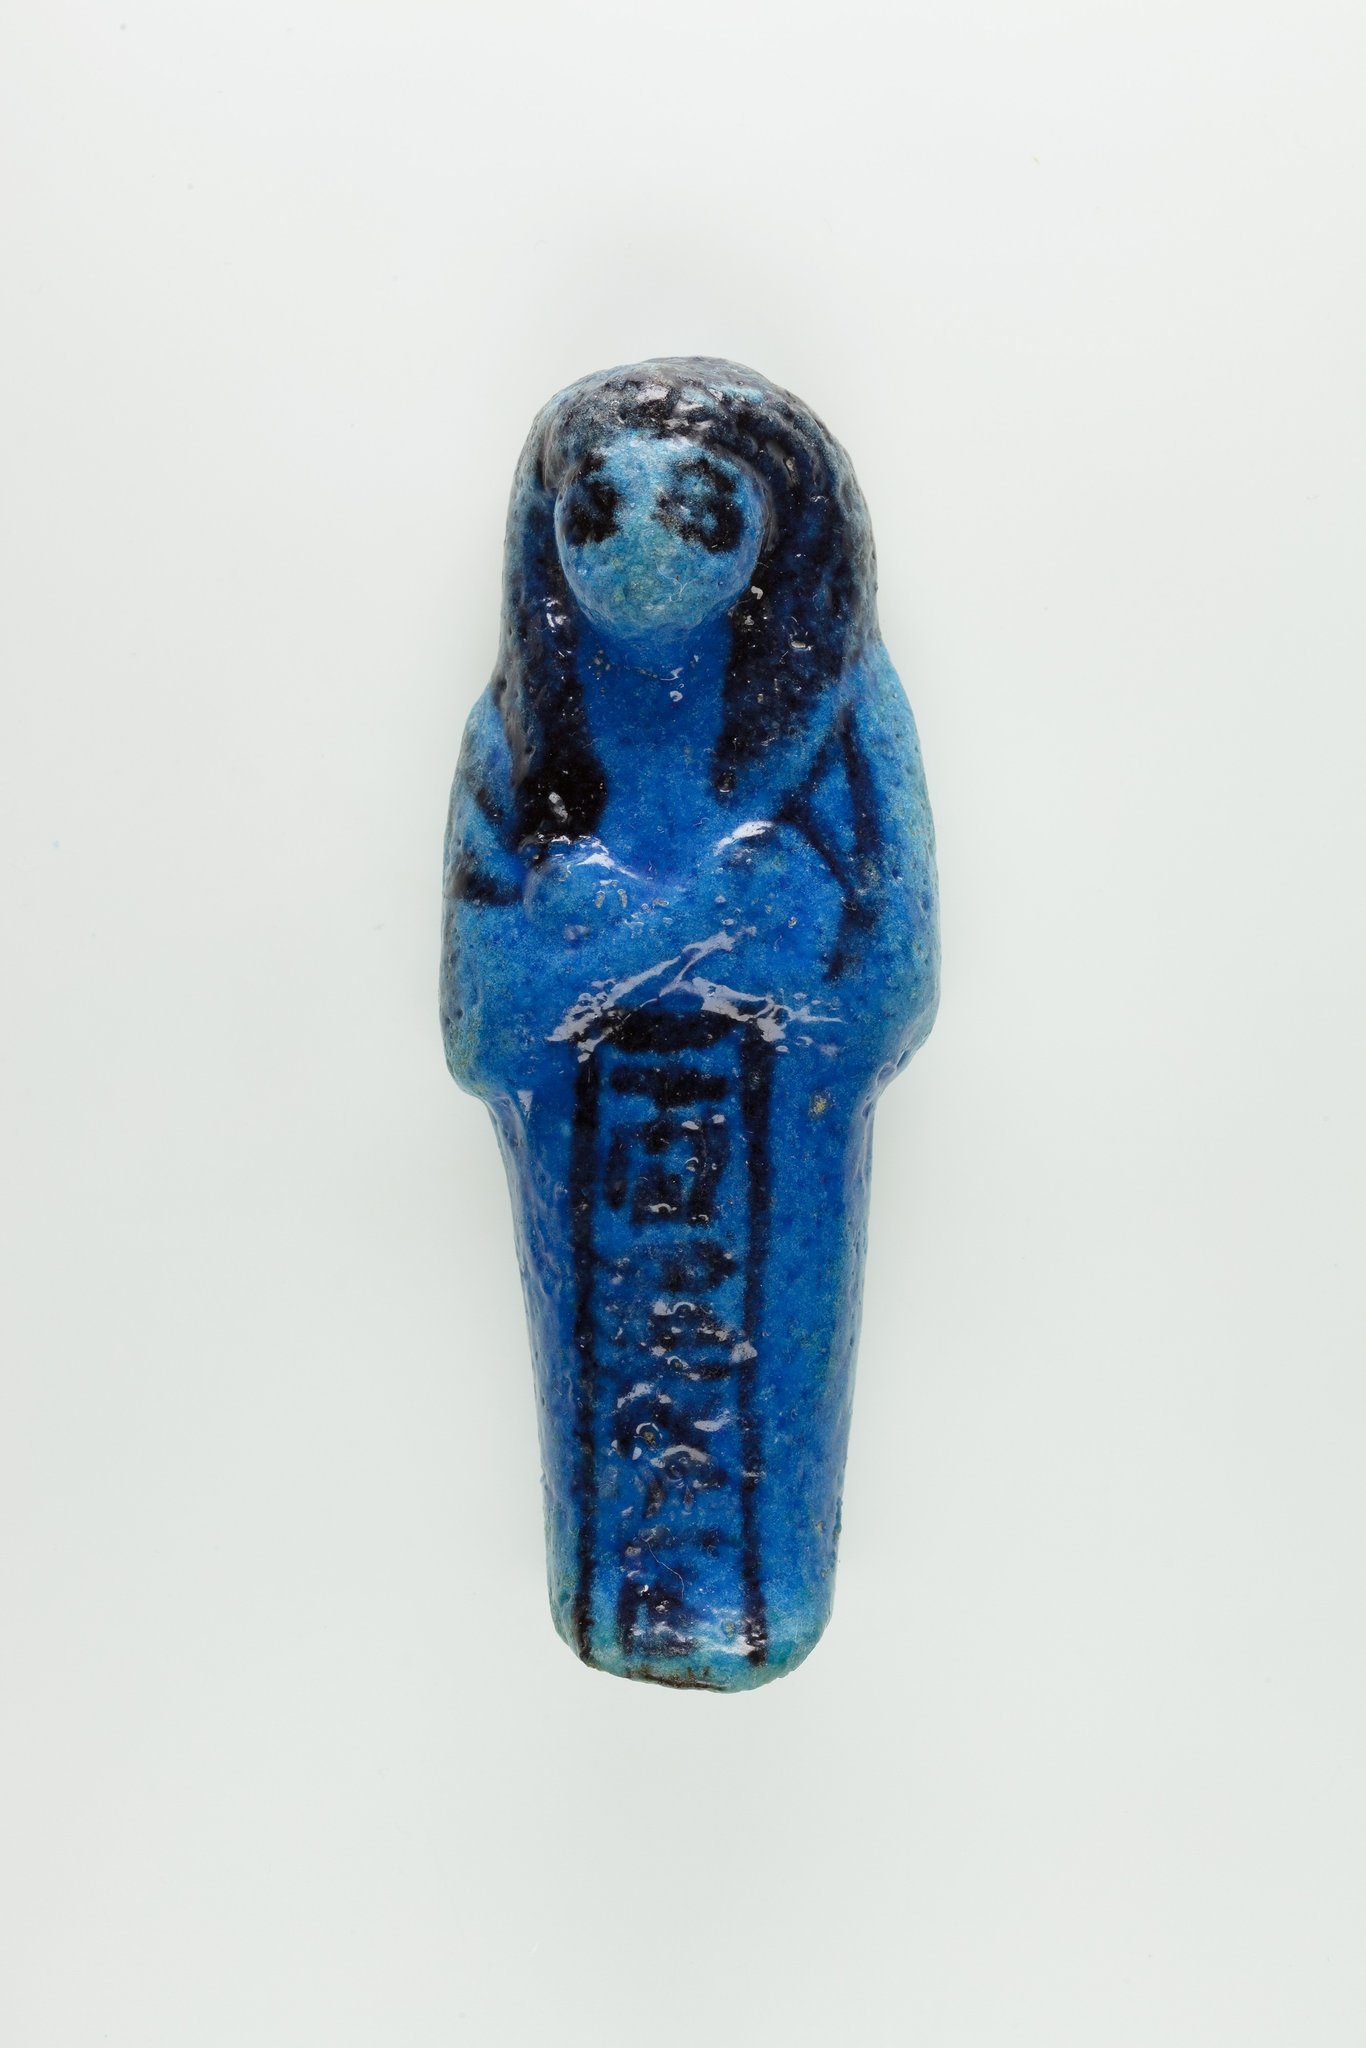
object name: shabti, worker, nauny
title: Worker Shabti of Nauny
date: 1050 BCE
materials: faience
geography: egypt